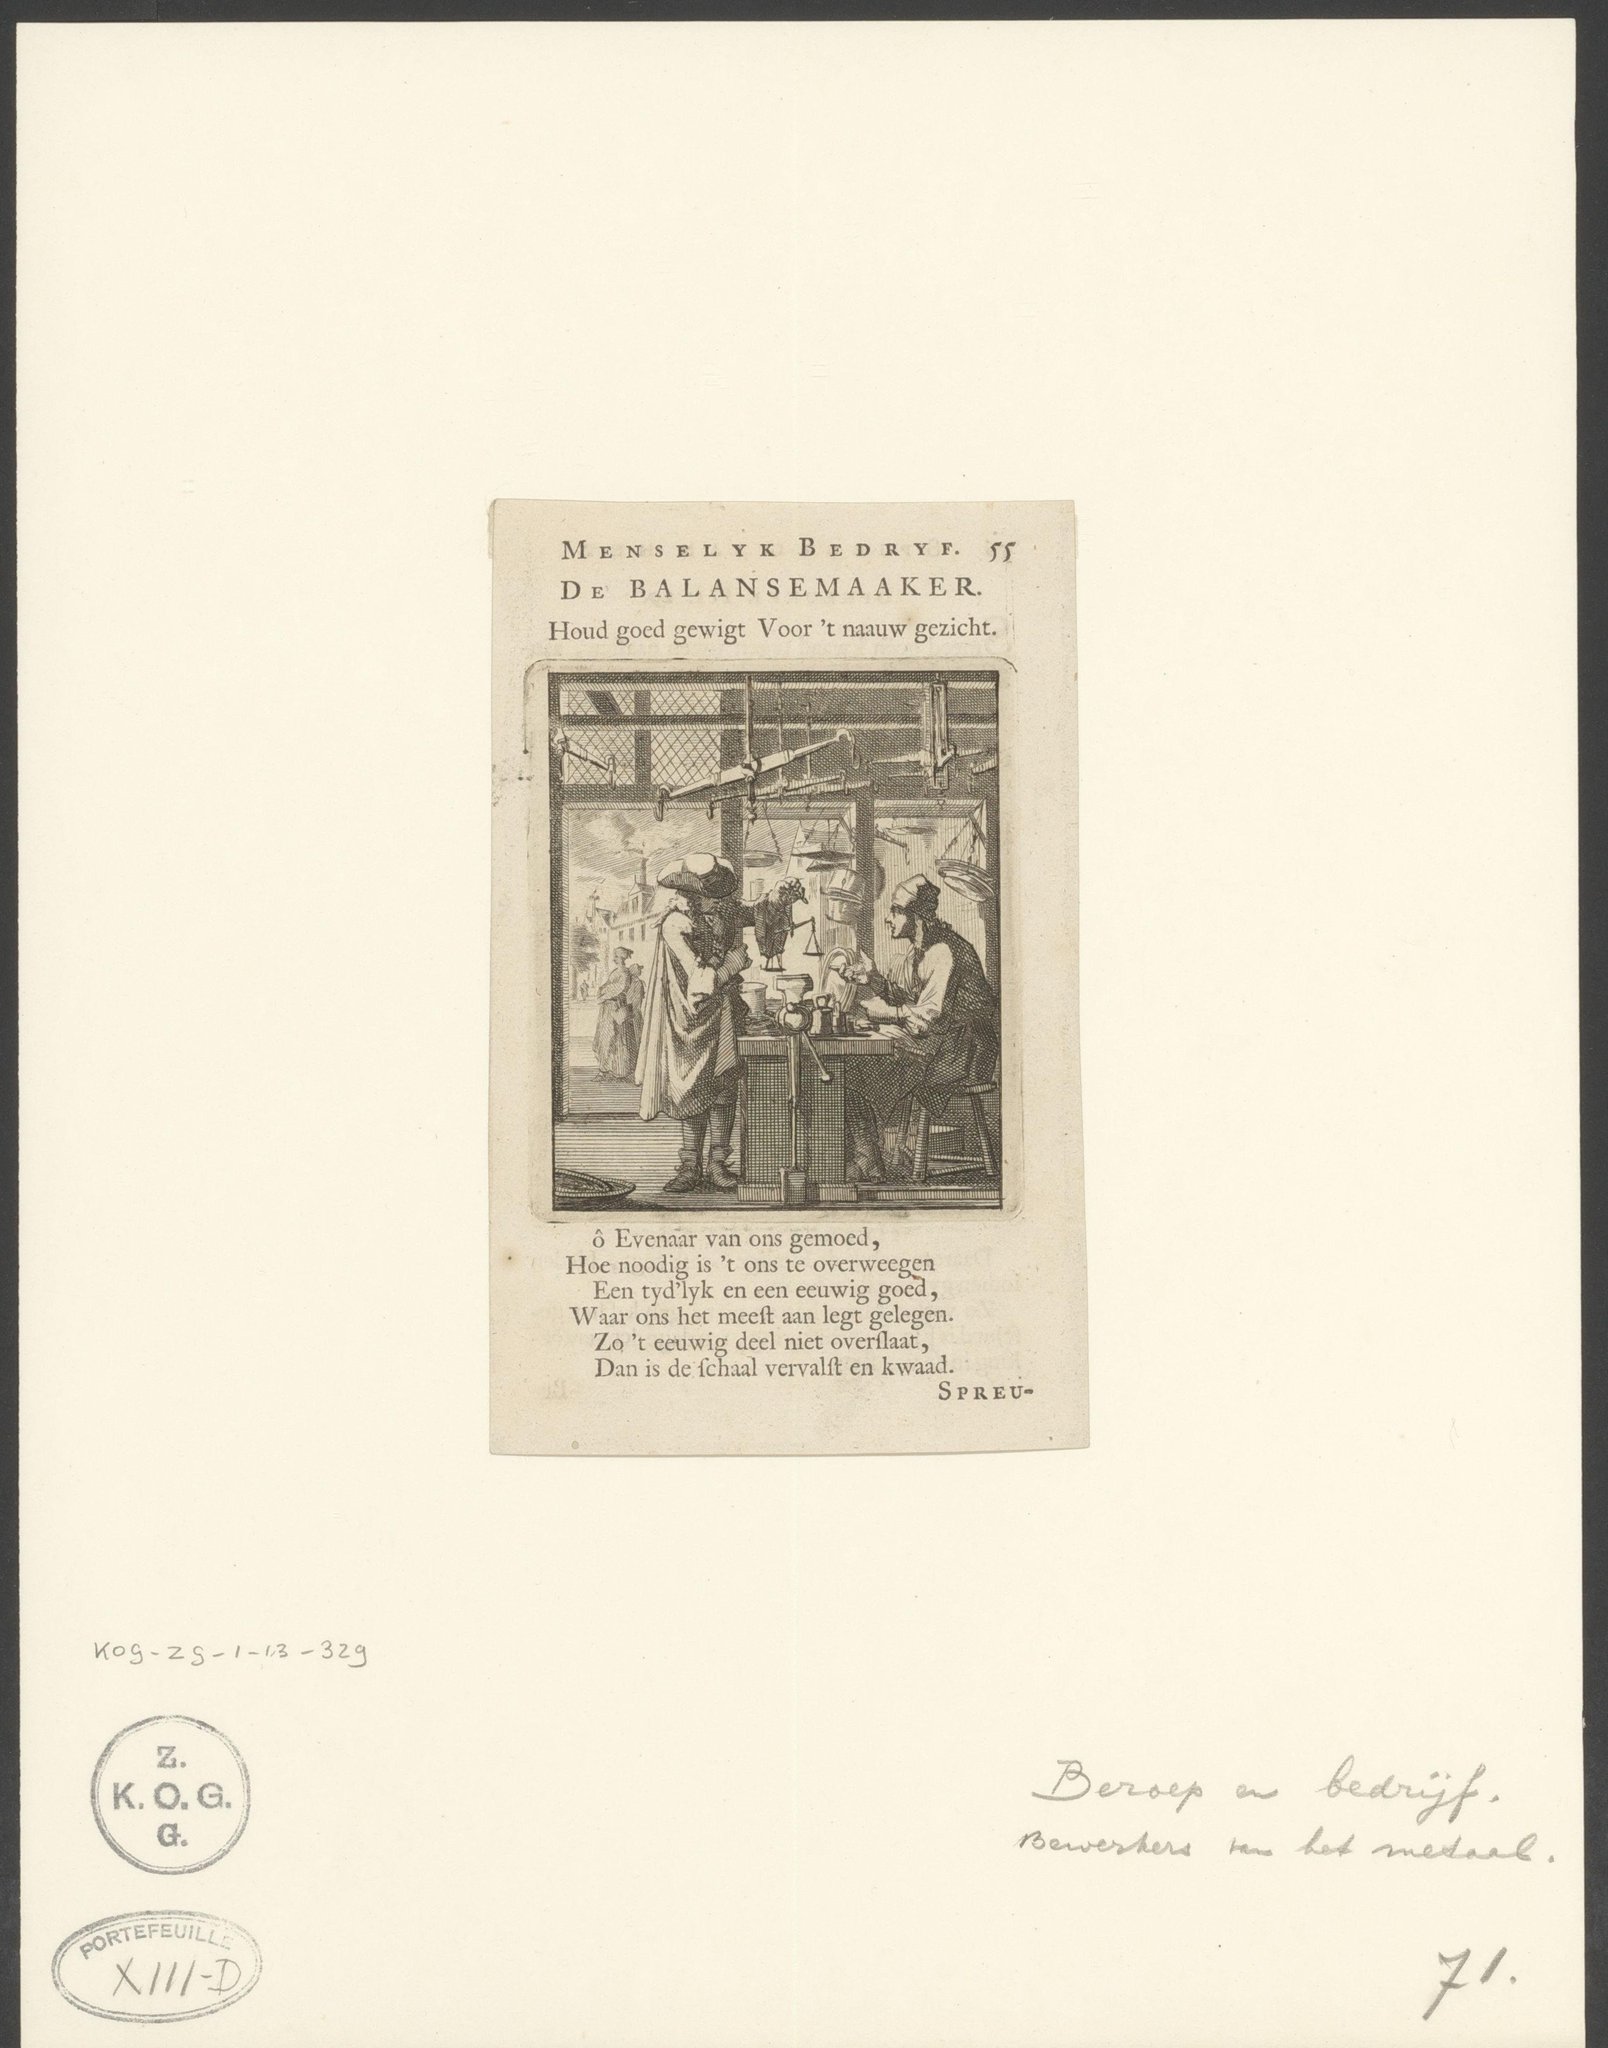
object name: book illustration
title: Weegschaalmaker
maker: cornelis van der sys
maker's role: publisher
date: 1718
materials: paper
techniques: etching, letterpress printing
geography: amsterdam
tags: handicrafts, craftsman at work, scales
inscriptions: stamp, stamp, collector's mark: Lugt 1641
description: Prent oorspronkelijk verschenen in de 100-delige serie beroepsprenten van Jan en Caspar Luyken, getiteld: Het menselyk bedryf. S.l.s.n., 1694 (eerste druk). Daarna zijn de verzen van de platen afgesneden en zijn de prenten in diverse publicaties verschenen en gekopieerd. Huidige staat uit: Luyken, Jan en Caspar. Spiegel van het menselyk bedryf (...). Amsterdam: Cornelis van der Sys, 1718, p. 55. Prent waarschijnlijk ook gebruikt in eerdere (1704) en latere (1730, 1749, 1767) publicaties.